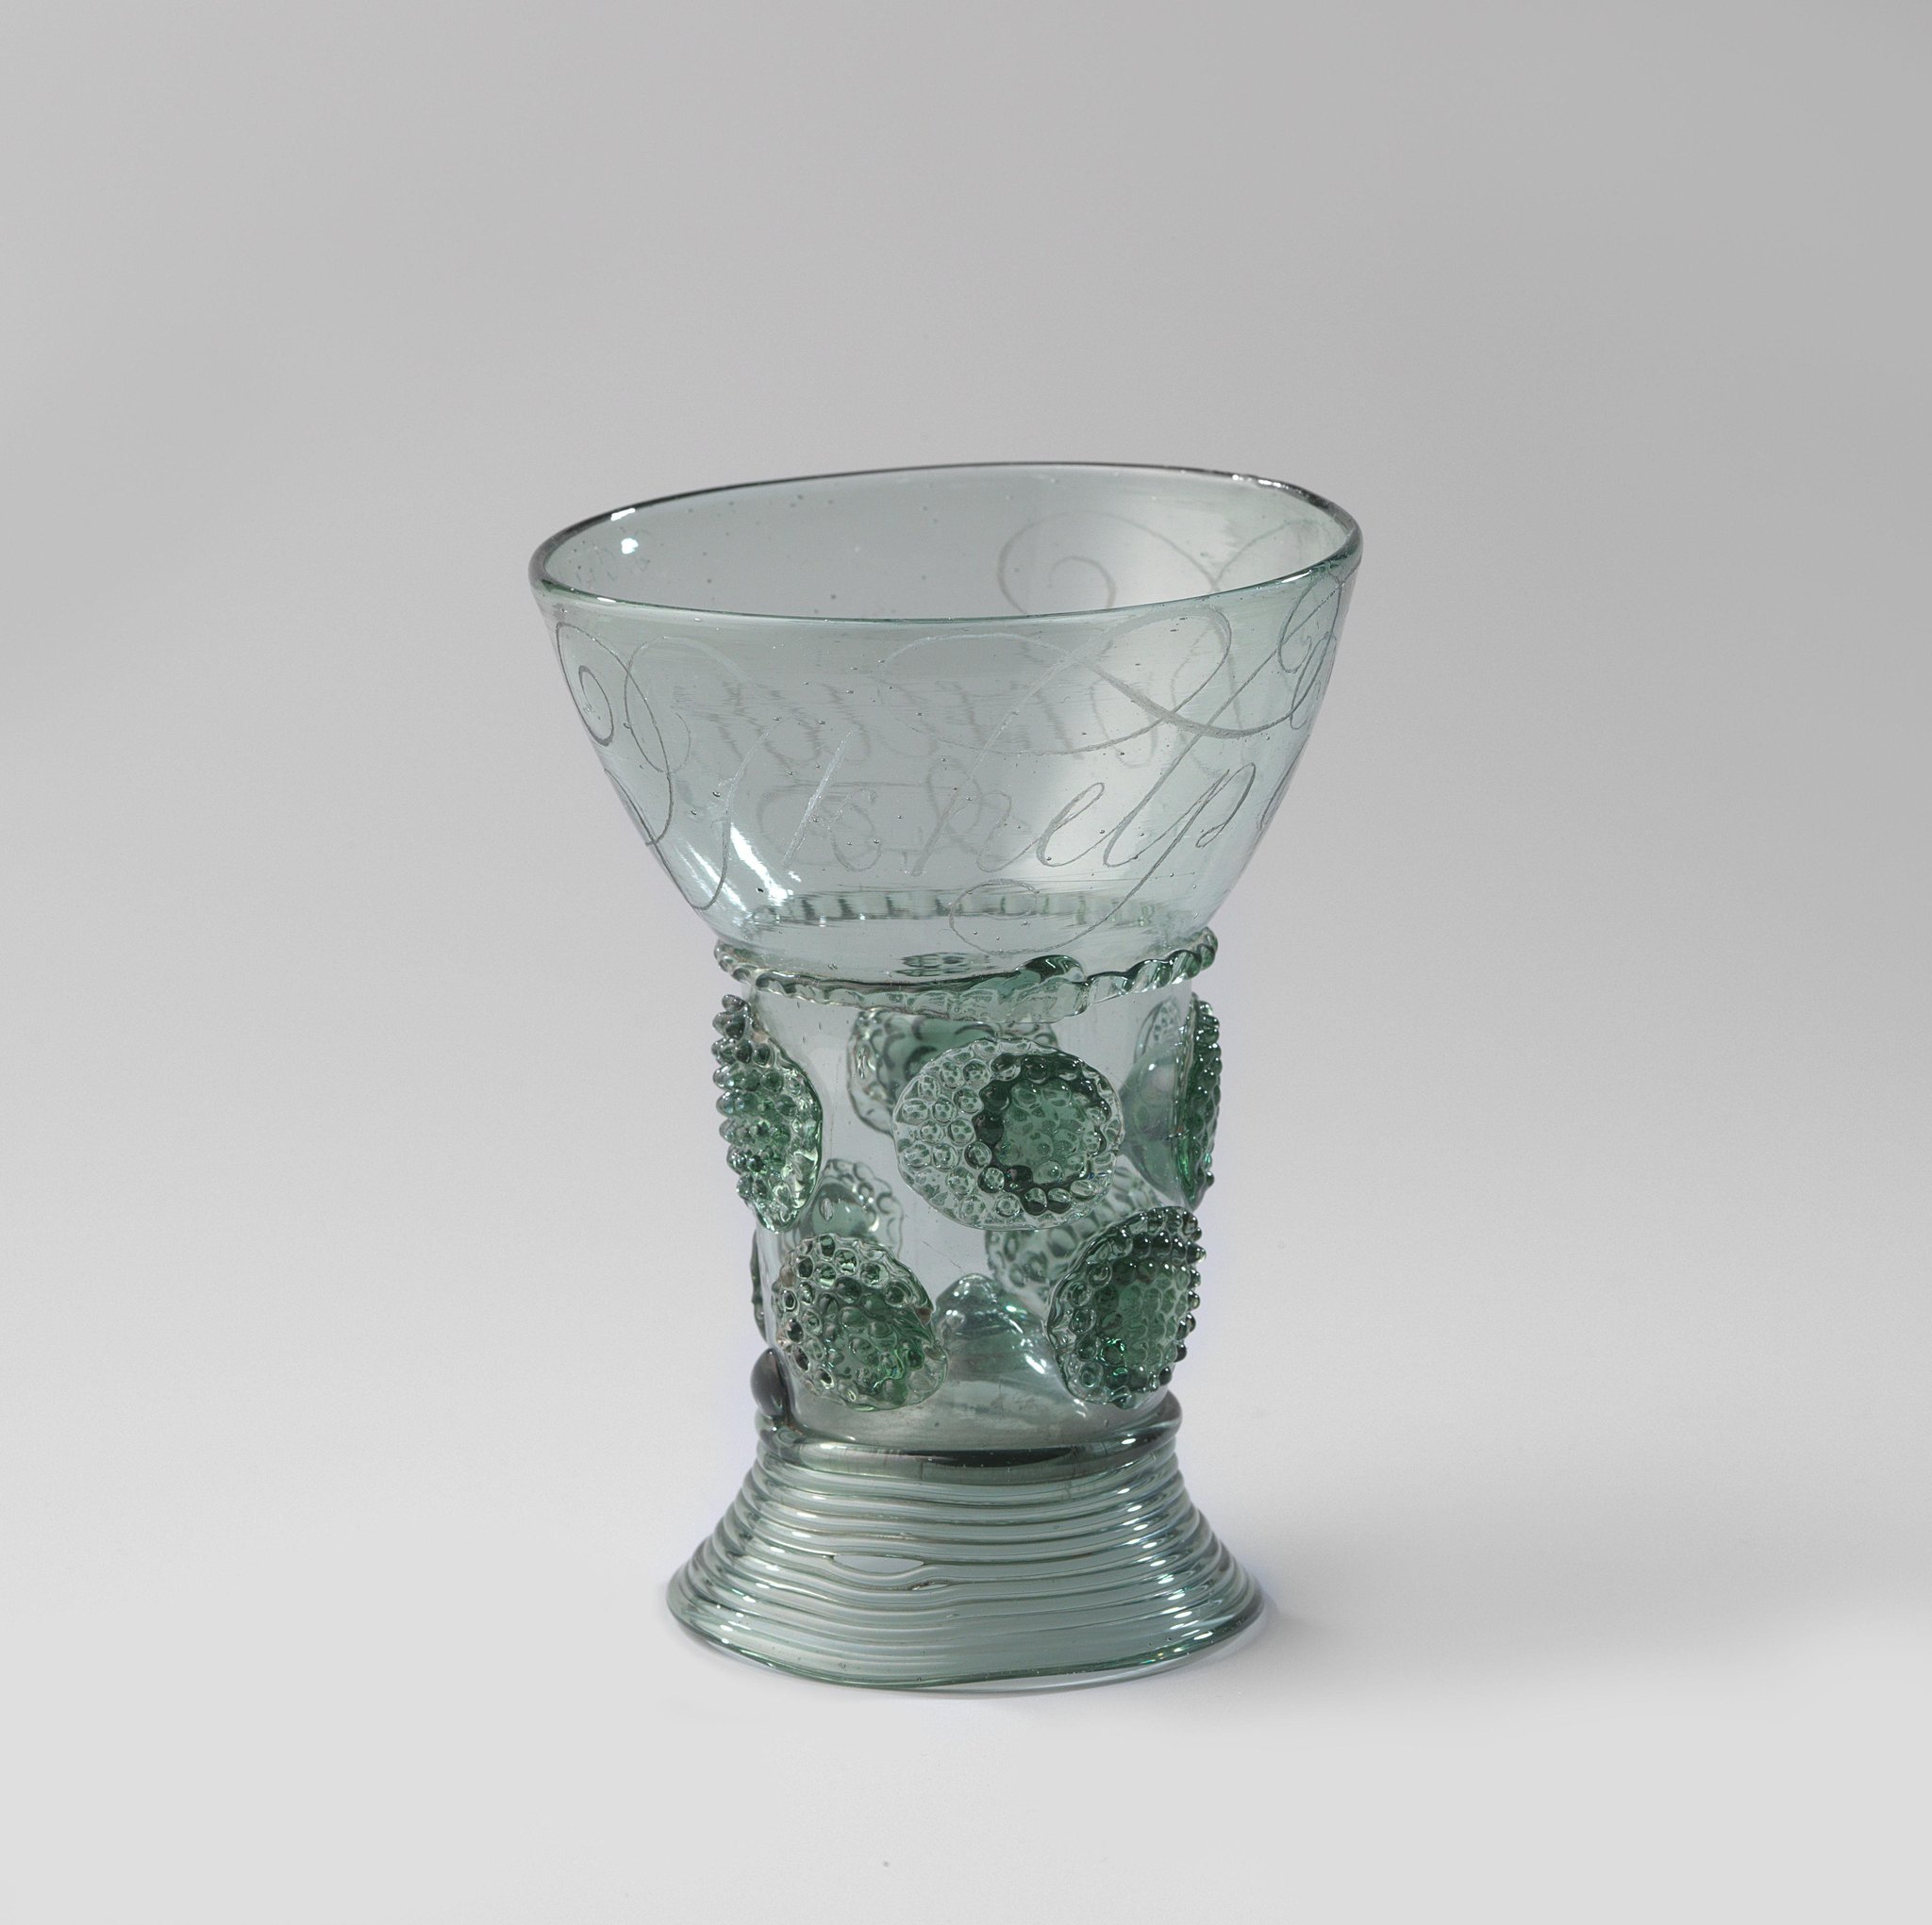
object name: berkenmeier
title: Berkenmeier met het opschrift: Ik help de Dorstige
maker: Anonymous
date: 1650-1700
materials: glass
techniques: diamond point engraving, glassblowing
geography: northern netherlands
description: Ingestoken ziel. Uit een draad gesponnen voet, van boven open stam, bezet met twee rijen platte braamnoppen, die naar binnen ingedrukt zijn. Trechter-vormige kelk, die van de stam wordt gescheiden door een geknepen draad. Op de kelk is in Italiaanse letters gecalligrafeerd 'Ik help de Dorstige'.